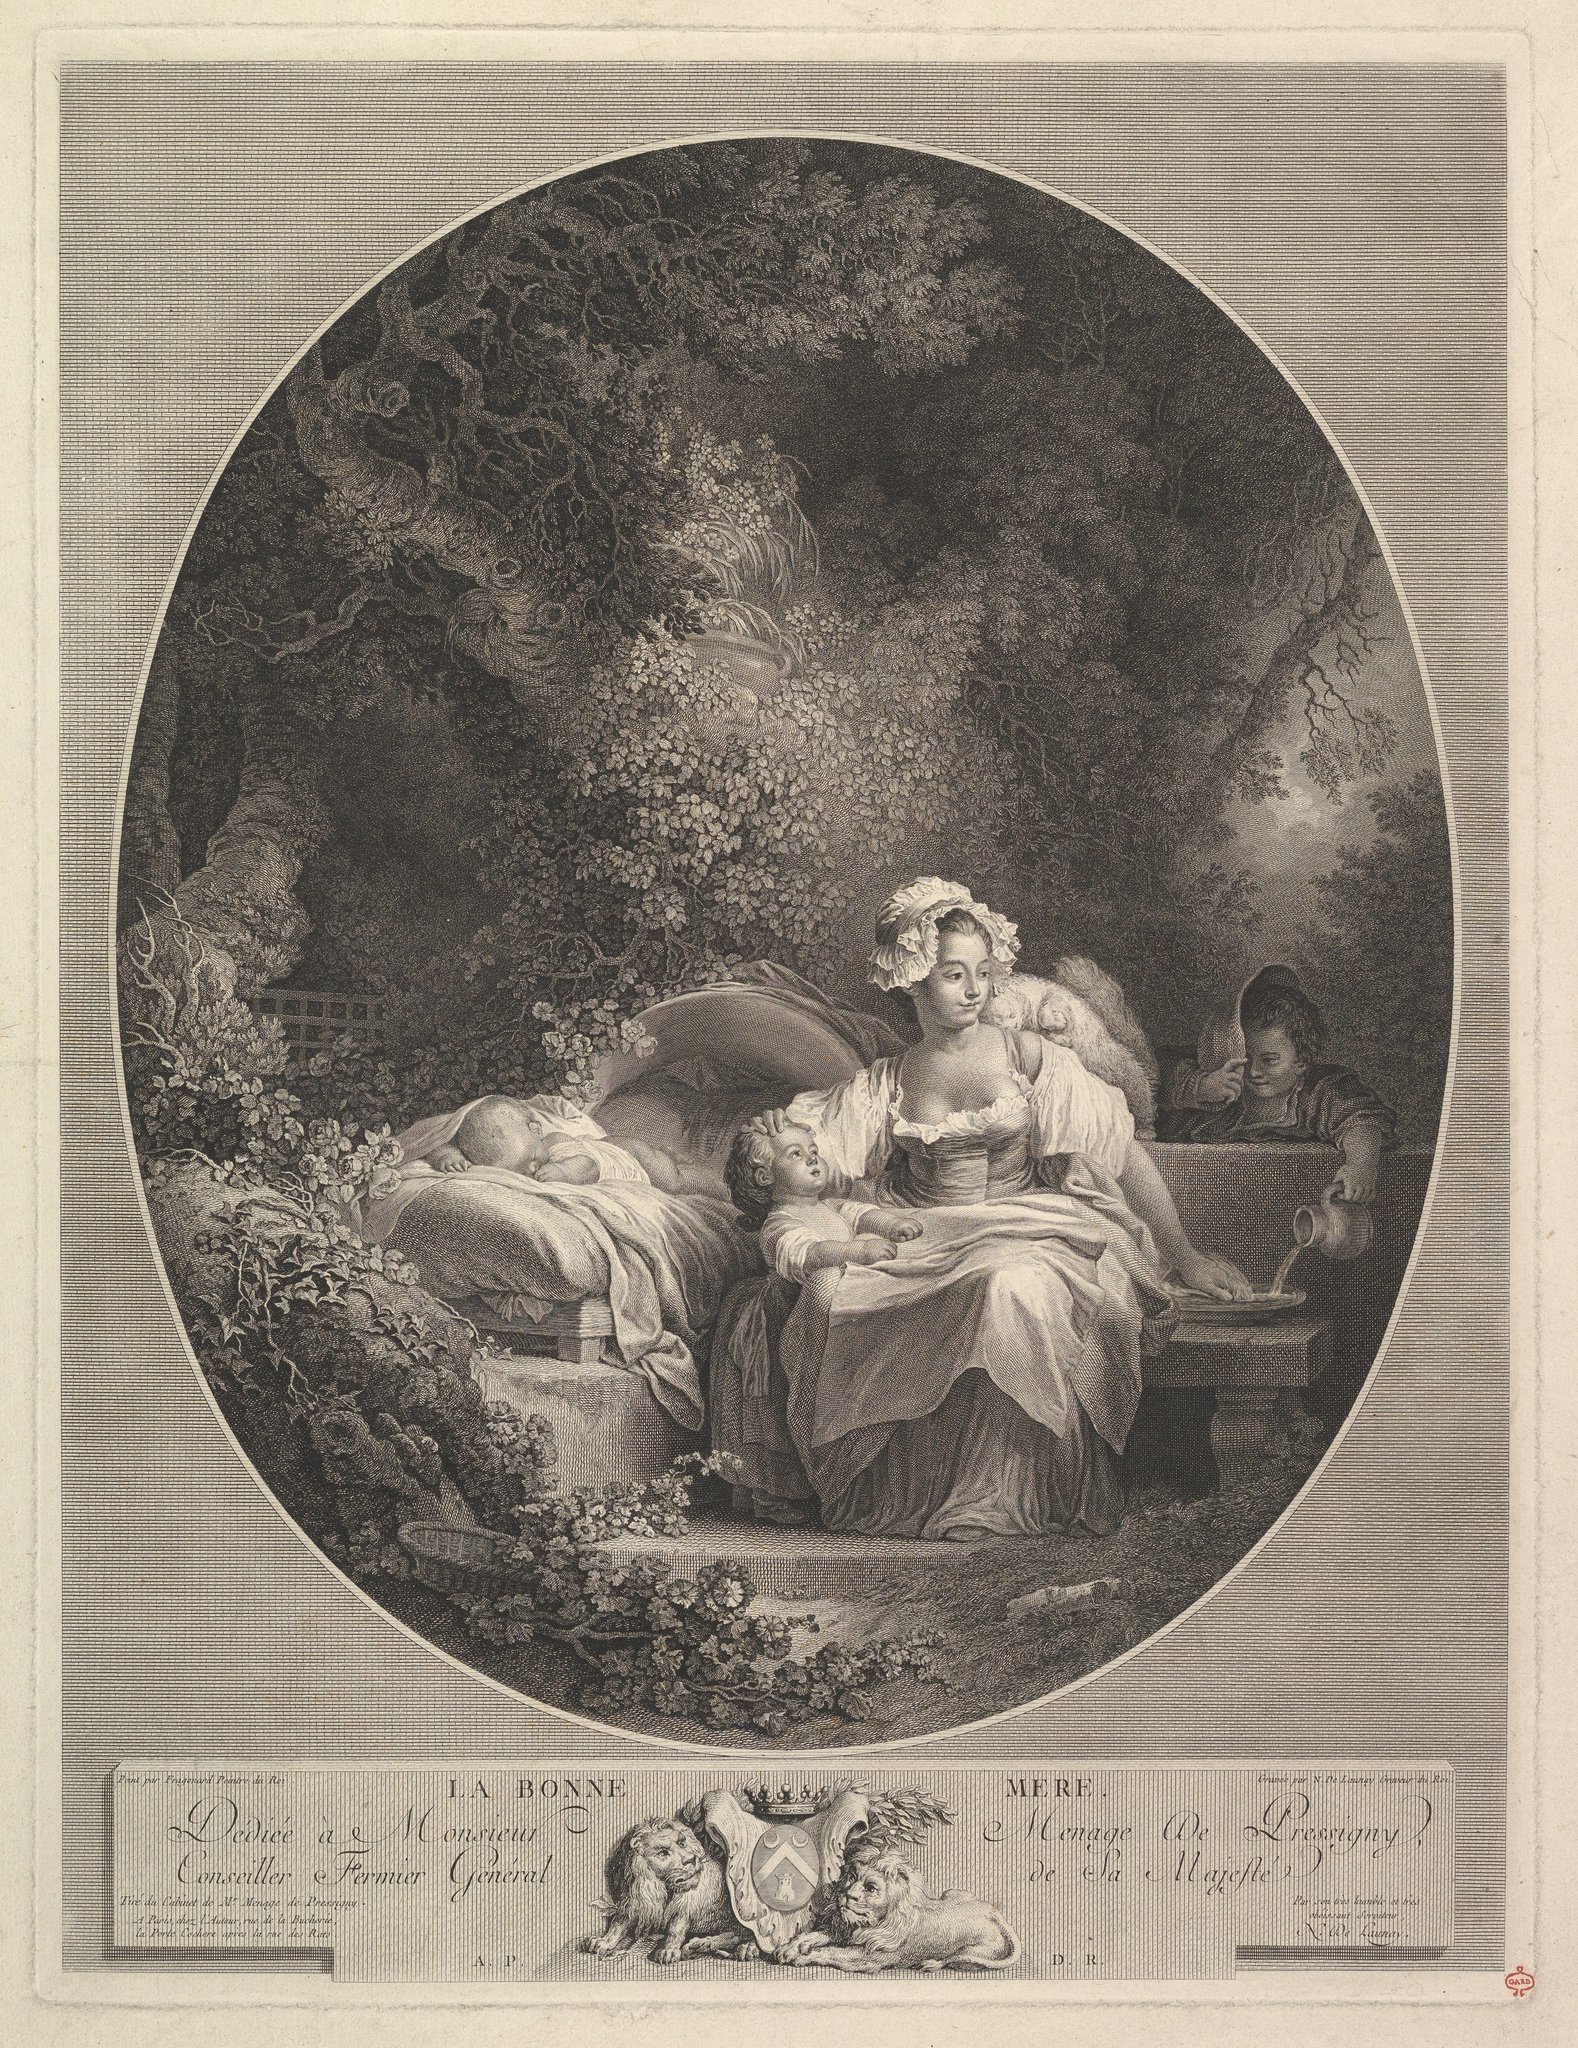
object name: print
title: La Bonne Mere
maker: jean honoré fragonard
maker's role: artist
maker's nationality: french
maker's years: 1732-1806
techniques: etching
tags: infants,women,lions,trees,coat of arms